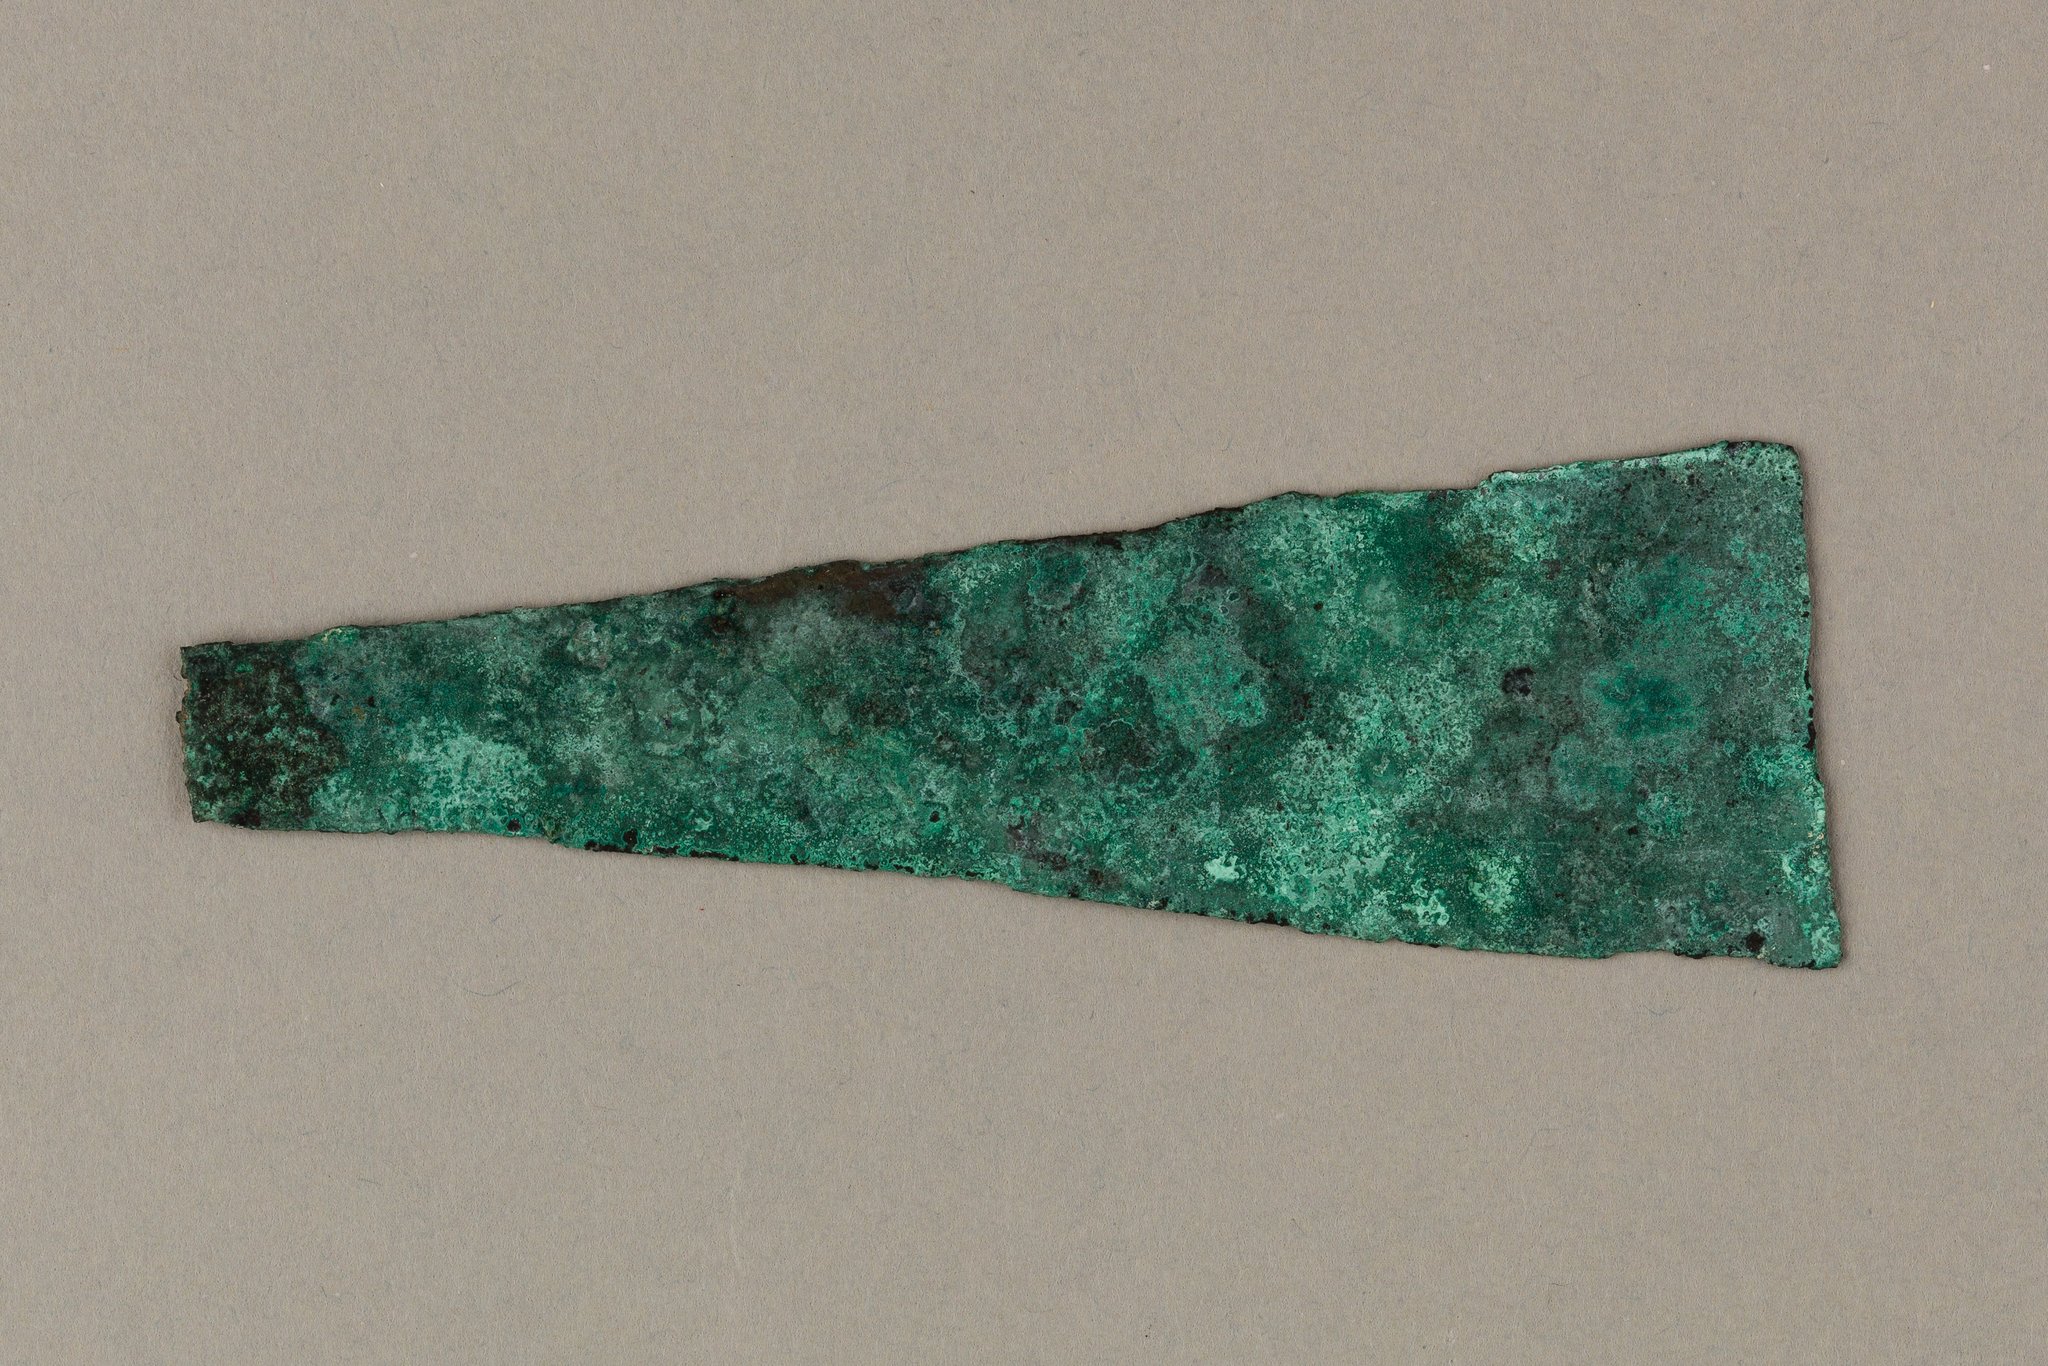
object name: model adze blade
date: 2650 BCE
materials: copper alloy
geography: egypt